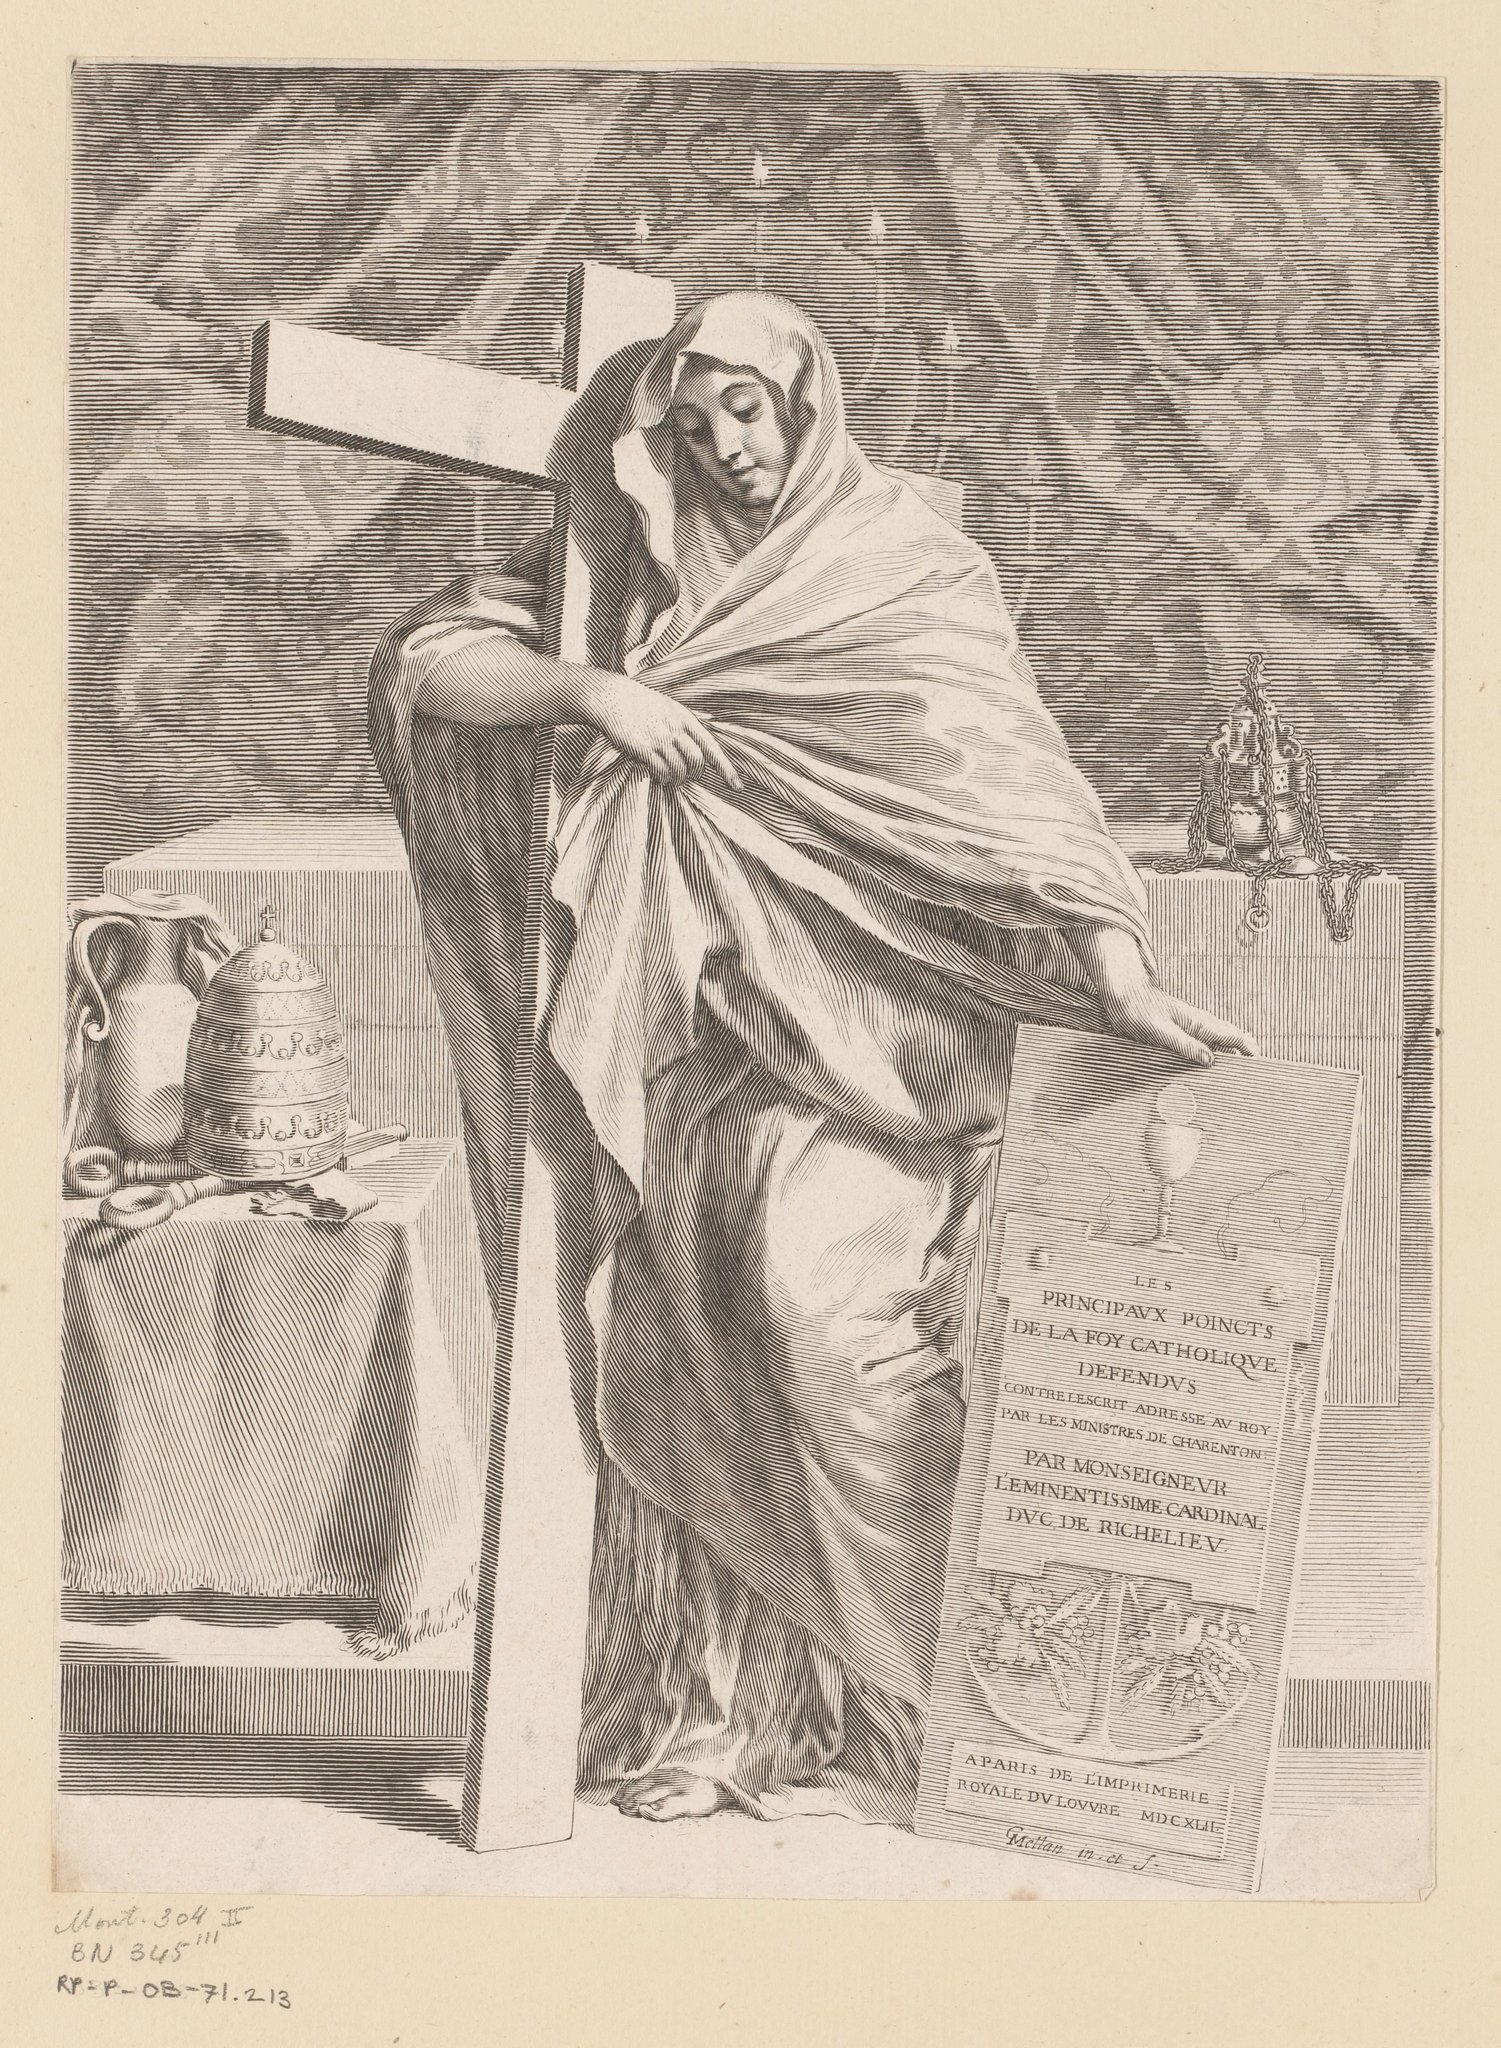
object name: print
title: Titelpagina voor: Armand-Jean du Plessis hertog van Richelieu, Les Principaux points de la foi de l'Eglise catholique (...), 1642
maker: claude mellan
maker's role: draughtsman, print maker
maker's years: 1598-1688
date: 1642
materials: paper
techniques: engraving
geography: france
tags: faith, 'fides'; 'fede', 'fede catholica', 'fede christiana', 'fede christiana catholica' (ripa) ~ one of the three theological virtues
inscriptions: collector's mark: Lugt 240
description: Titelpagina voor: Richelieu, Armand-Jean du Plessis hertog van. Les Principaux poincts de la foy catholique défendus contre contre l'escrit adressé au Roy par les ministres de Charenton. Parijs: Imprimerie Royale, 1642.